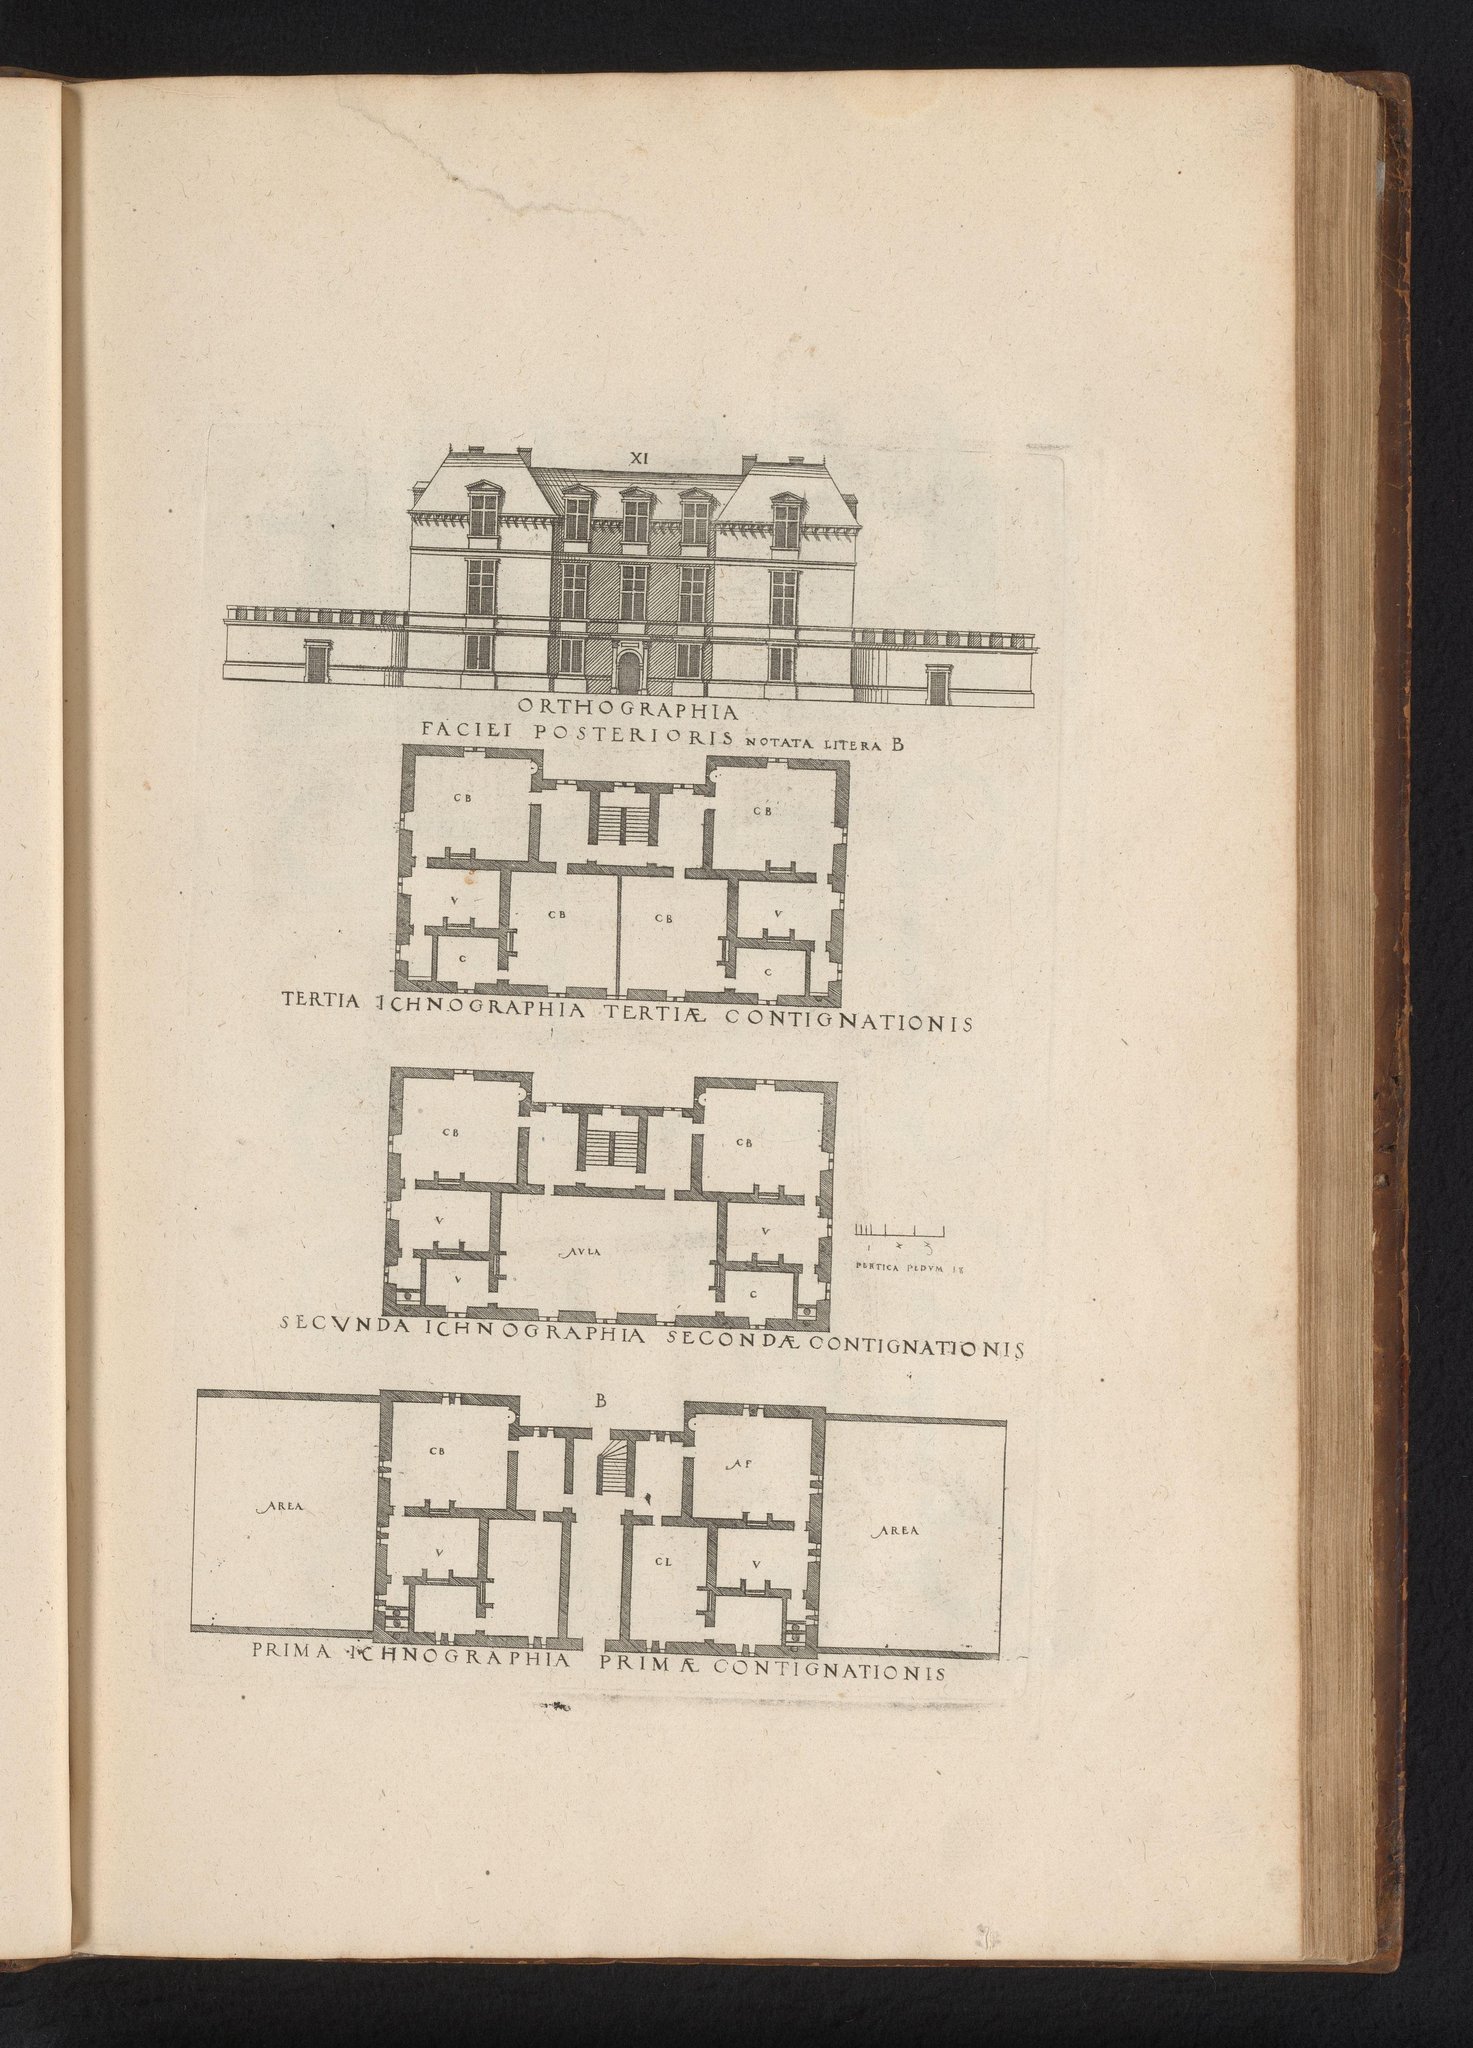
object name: ornament print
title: Achtergevel en plattegronden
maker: jacques androuet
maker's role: draughtsman, print maker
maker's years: 1515-1584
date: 1559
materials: paper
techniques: etching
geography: paris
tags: façade (of house or building), plan ~ architecture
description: Achtergevel en plattegronden. Aanzicht en plattegronden van architectuur. Genummerd: XI. Onderdeel van 'De architectura Iacobi Androuetii du Cerceau' (1559): 69 etsen met 171 voorstellingen van architectuur en ornamentiek.